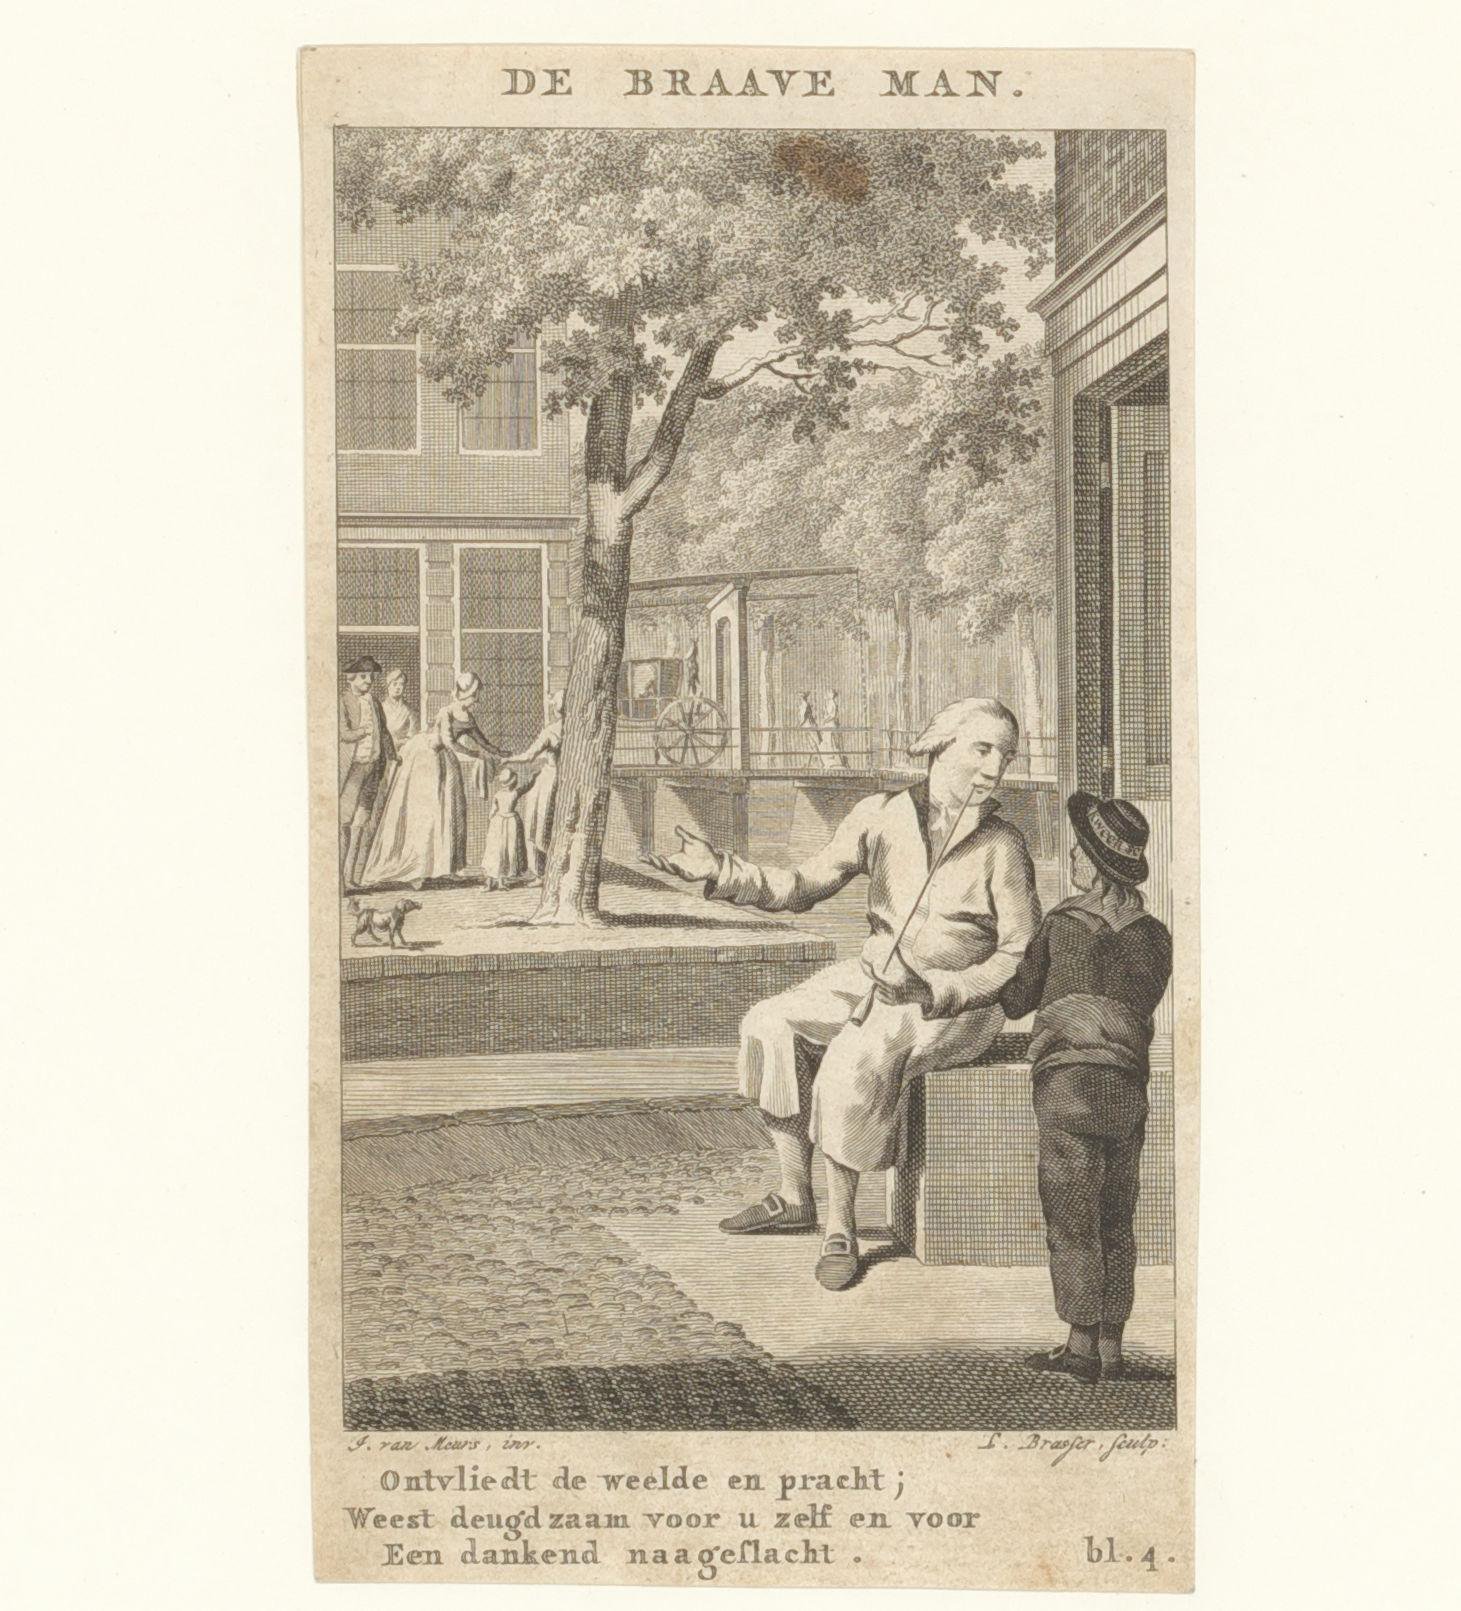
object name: book illustration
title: De braave man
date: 1789-1791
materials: paper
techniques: engraving, etching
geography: netherlands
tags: pipe ~ tobacco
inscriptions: collector's mark, collector's mark: Lugt 1641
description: Gebruikt als illustratie in: Volks-liedjes, uitgegeven door de Maatschappij tot Nut van 't Algemeen, Amsterdam: Harmanus Keijzer, Arend Fokke en Cornelis de Vries, 3 delen, 1789-1791, p. 3/4.